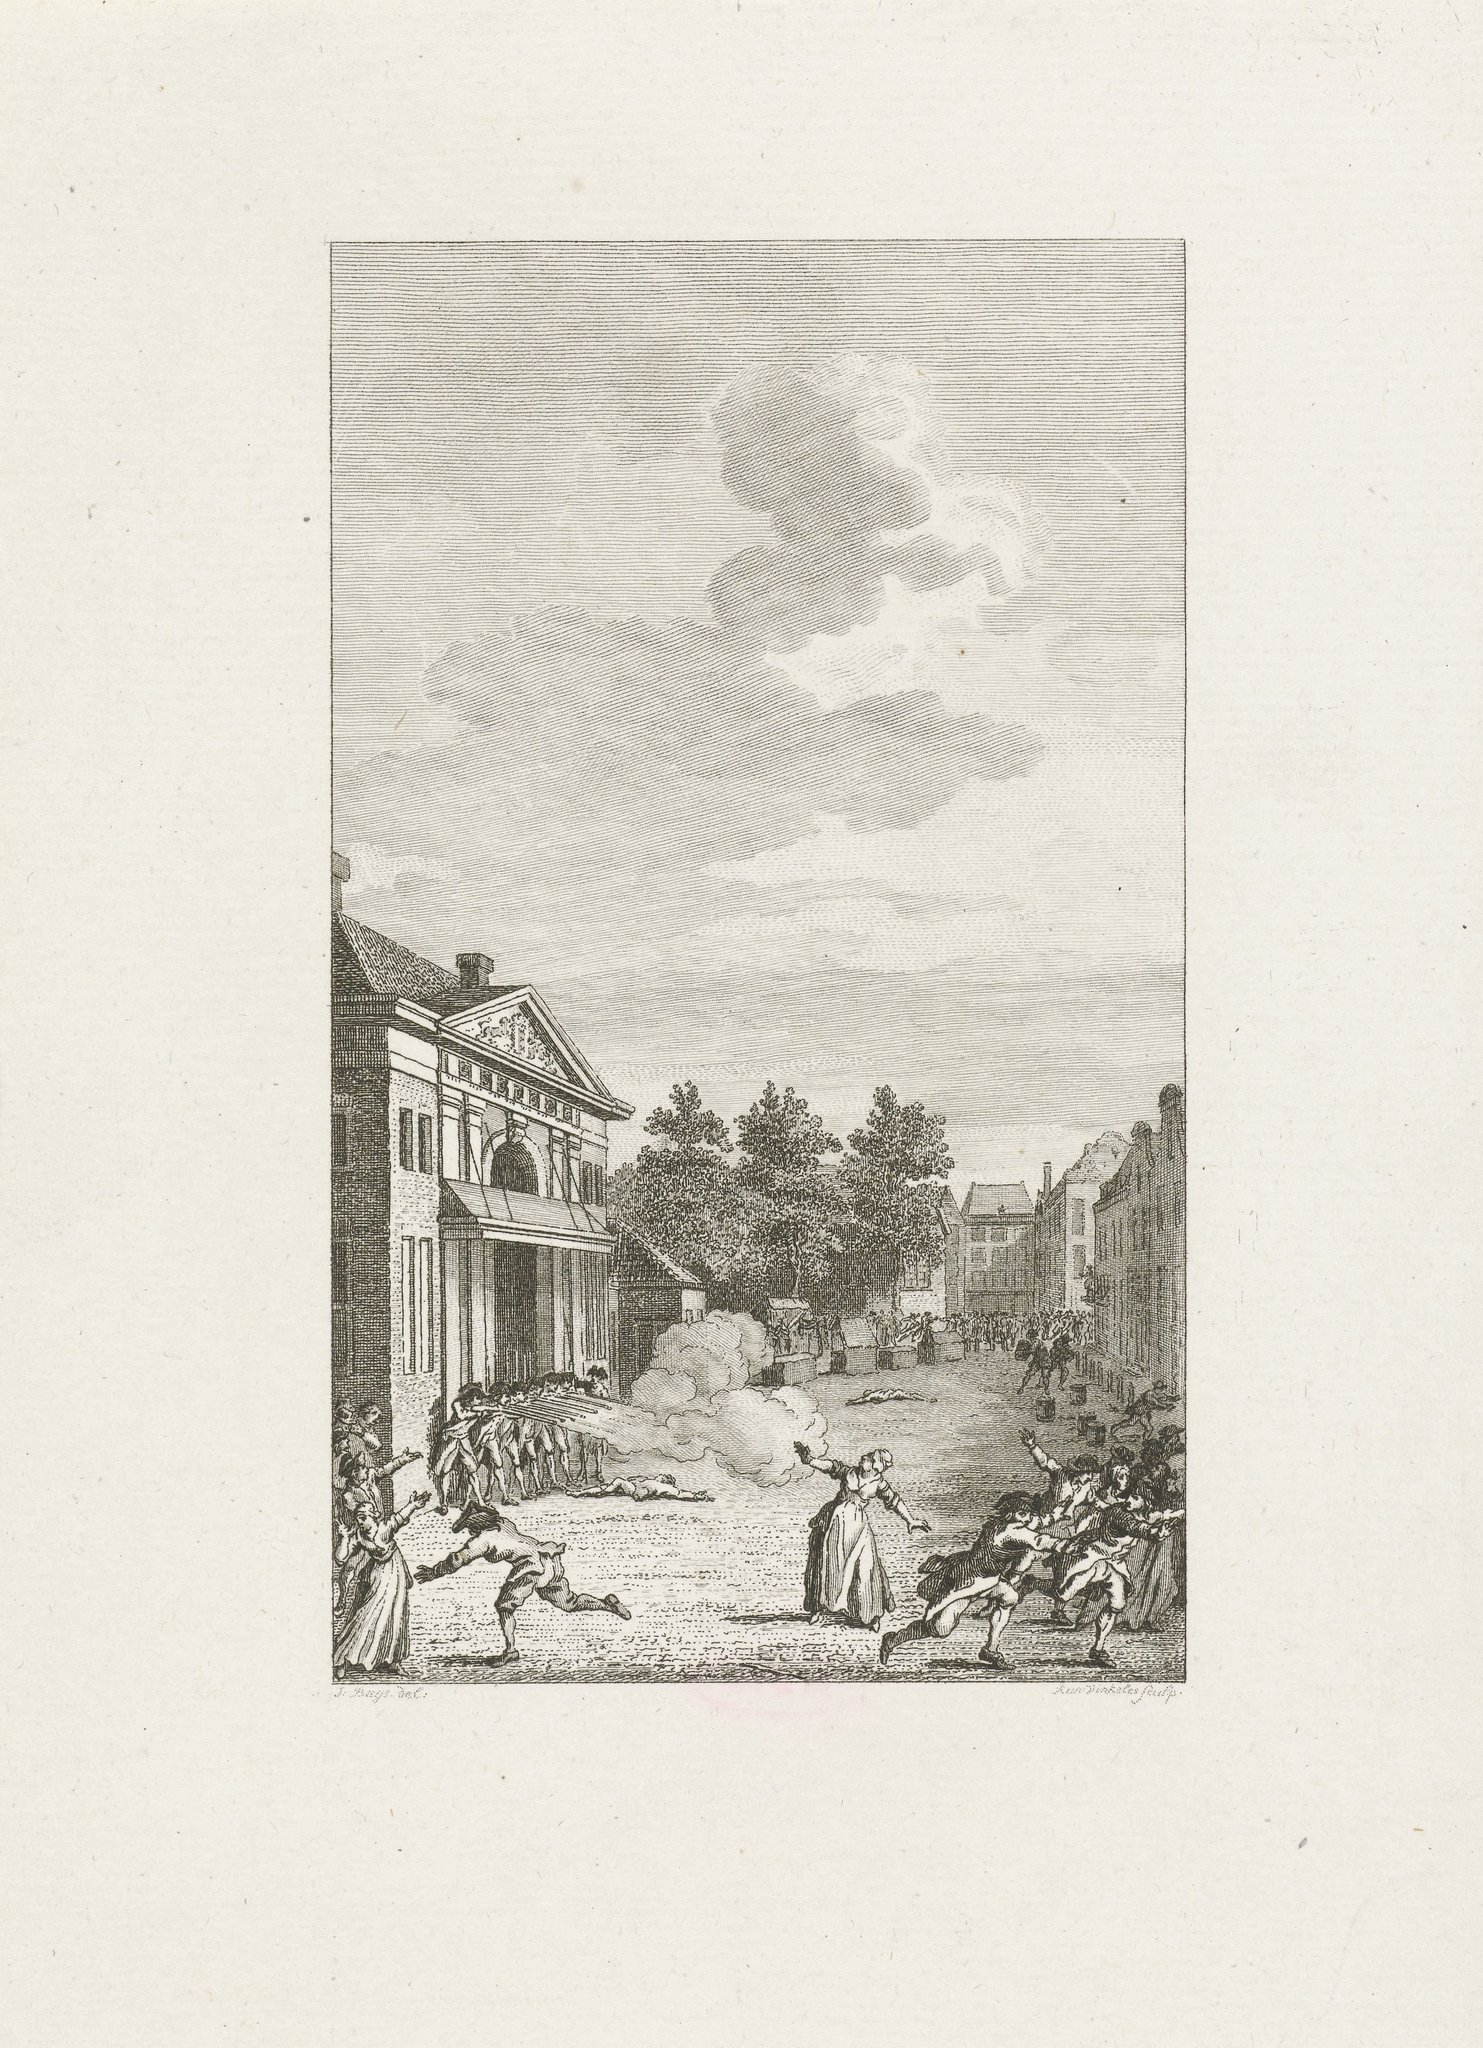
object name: print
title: Oproer op de Botermarkt te Amsterdam 1748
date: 1794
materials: paper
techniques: etching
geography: northern netherlands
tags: street-fights, riots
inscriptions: collector's mark: Lugt 2228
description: Oproer op de Botermarkt te Amsterdam 1748. Soldaten staande voor het Waaggebouw (Regulierswaag of Boterwaag) schieten op rellende burgers.